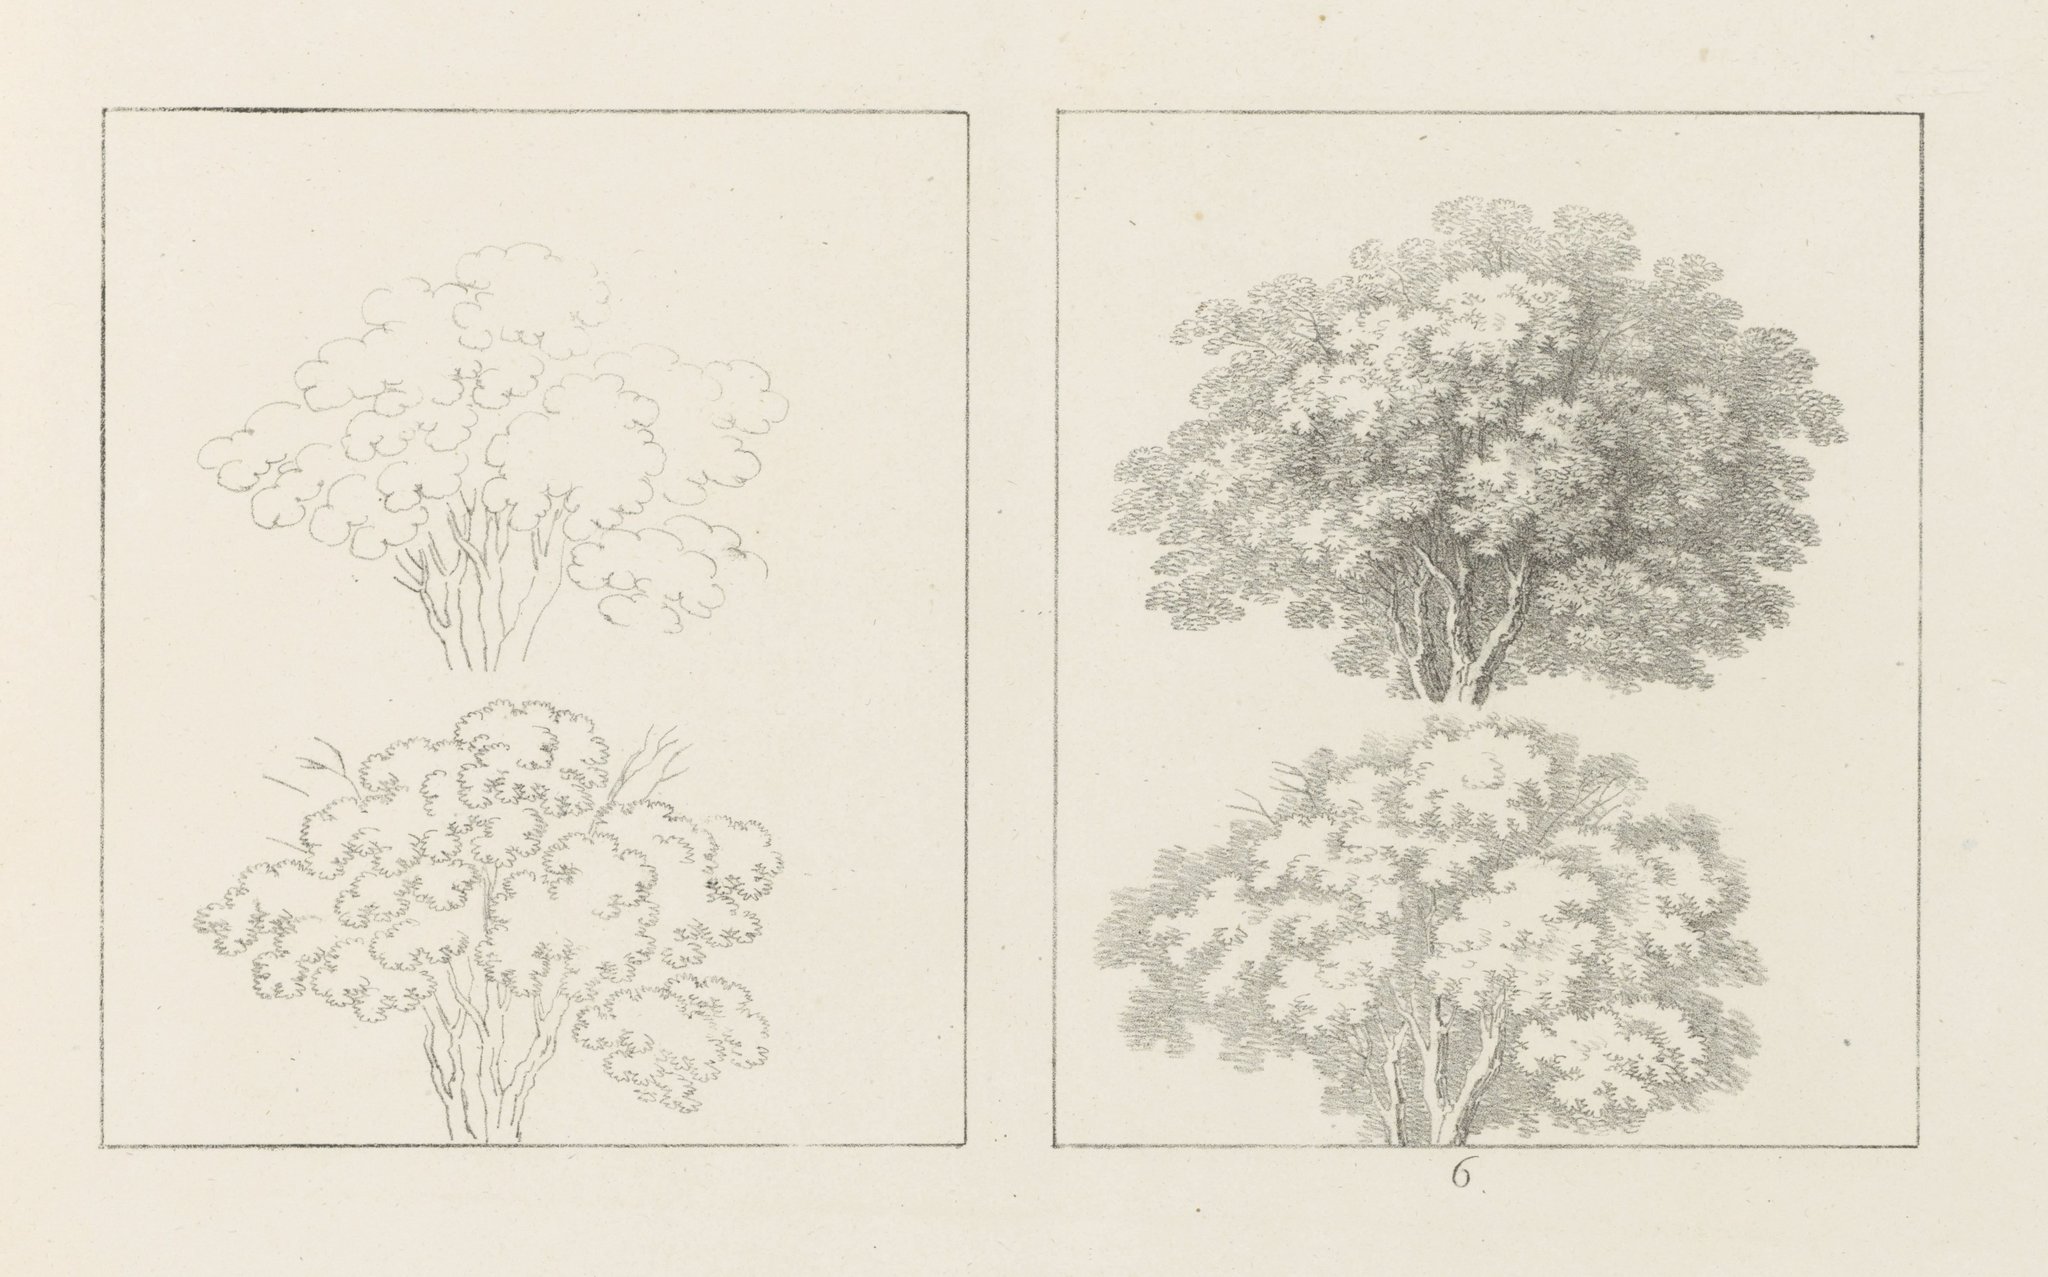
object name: print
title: Albumblad met twee voorstellingen van bomen vol bladeren: links het ontwerp, rechts de uitvoering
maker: max josef wagenbauer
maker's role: print maker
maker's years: 1774-1829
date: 1816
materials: paper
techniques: lithograph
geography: munich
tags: trees, the graphic arts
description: Albumblad met twee voorstellingen van bomen vol bladeren: links het ontwerp, rechts de uitvoering. Maakt deel uit van een album met 18 bladen met studies van bomen.